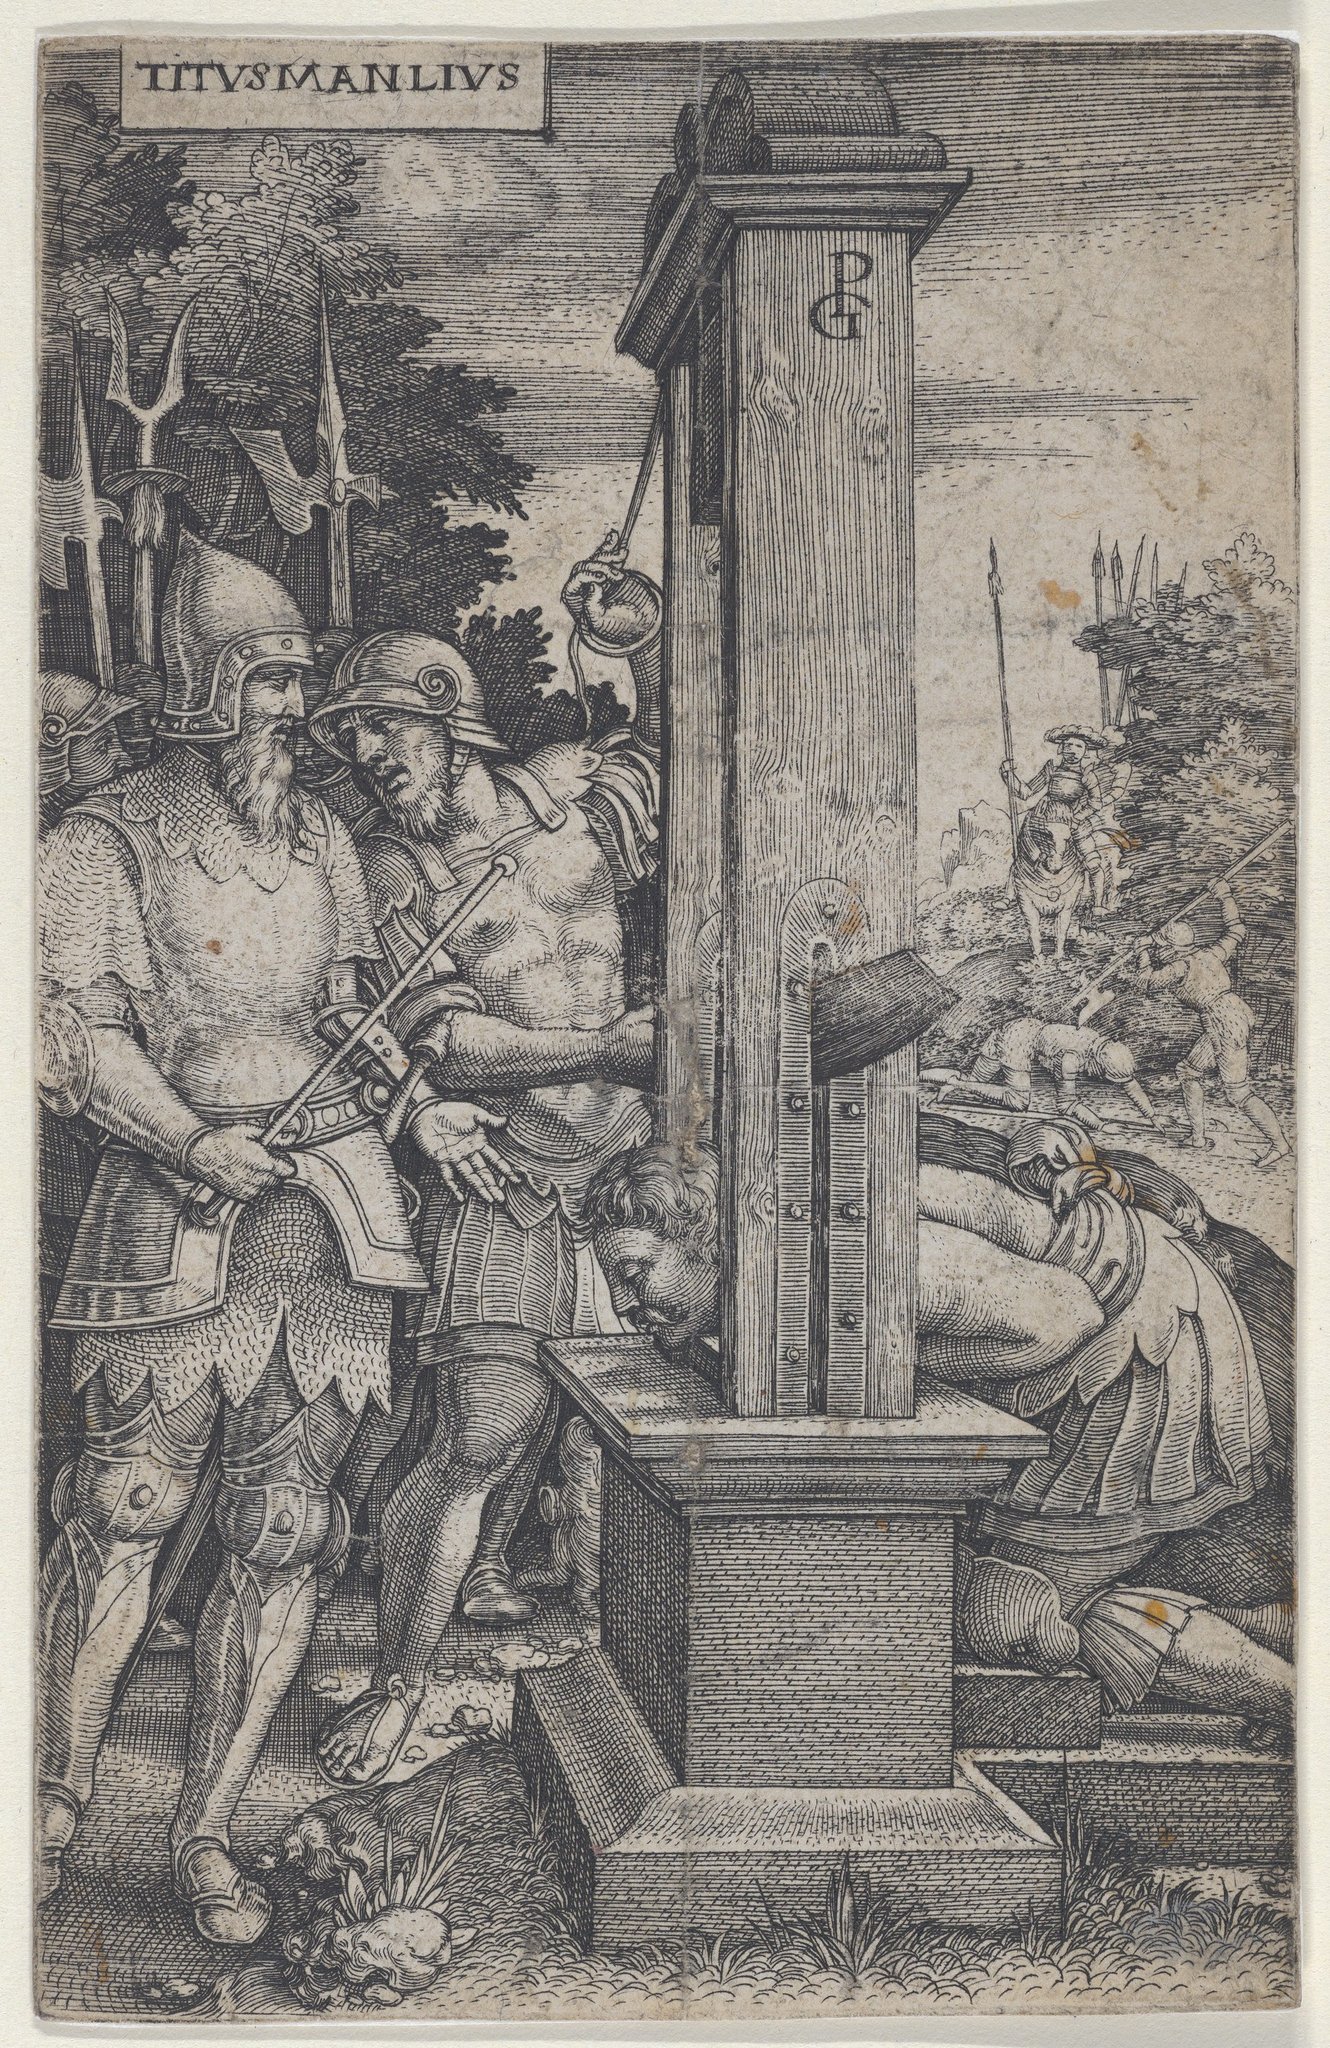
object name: print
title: Titus Manlius, from "Roman Heroes"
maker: georg pencz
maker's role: artist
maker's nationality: german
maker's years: 1500-1550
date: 1535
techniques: engraving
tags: soldiers,weapons,men,execution